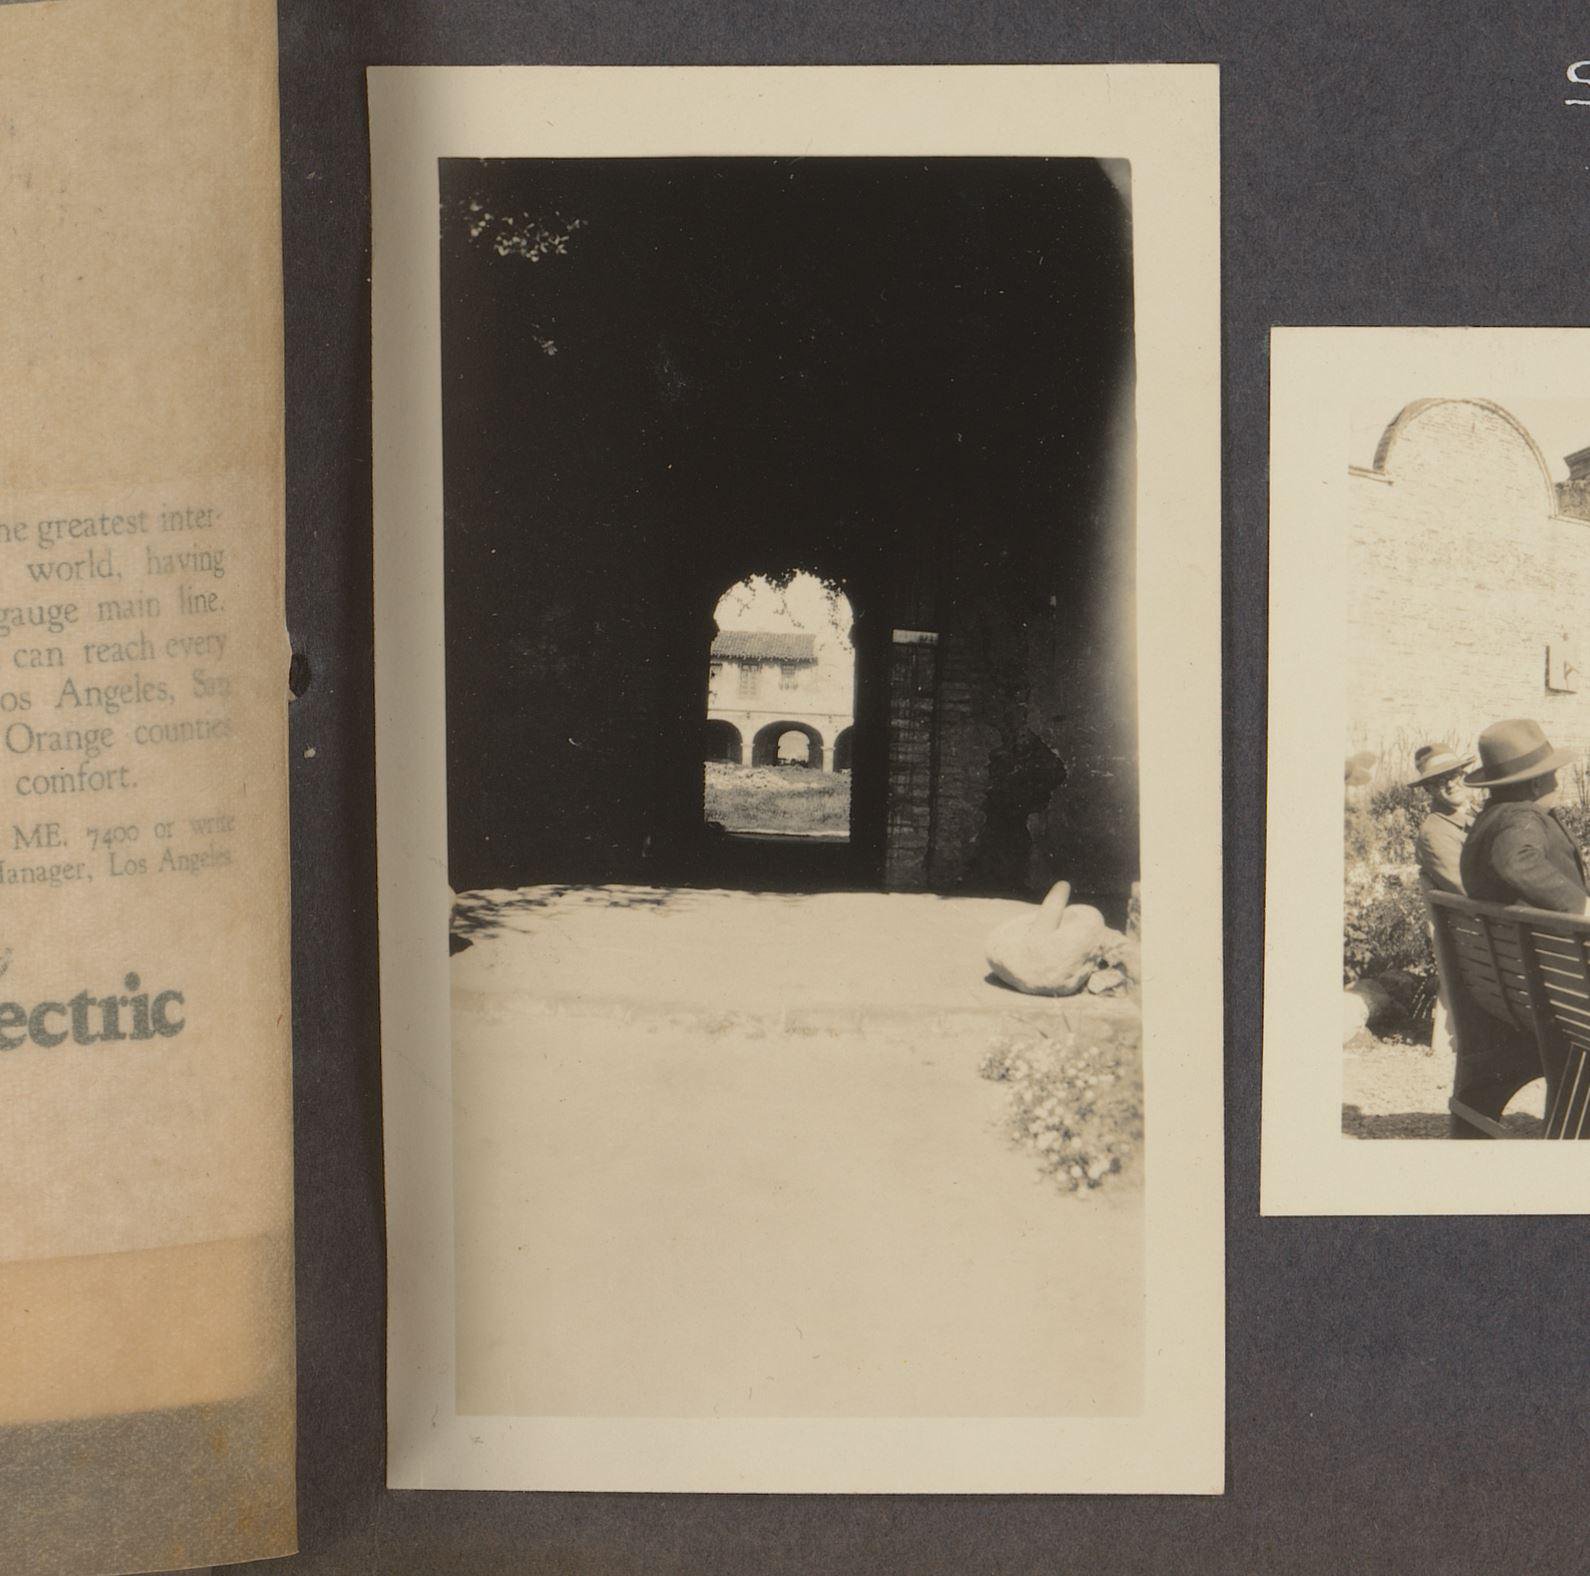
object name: photograph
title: Gezicht op de binnenplaats door een poort bij Mission San Juan Capistrano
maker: Anonymous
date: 1928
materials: photographic support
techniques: gelatin silver print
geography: san juan capistrano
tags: gate, entrance, courtyard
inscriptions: annotation: ‘San Juan Capistrano’